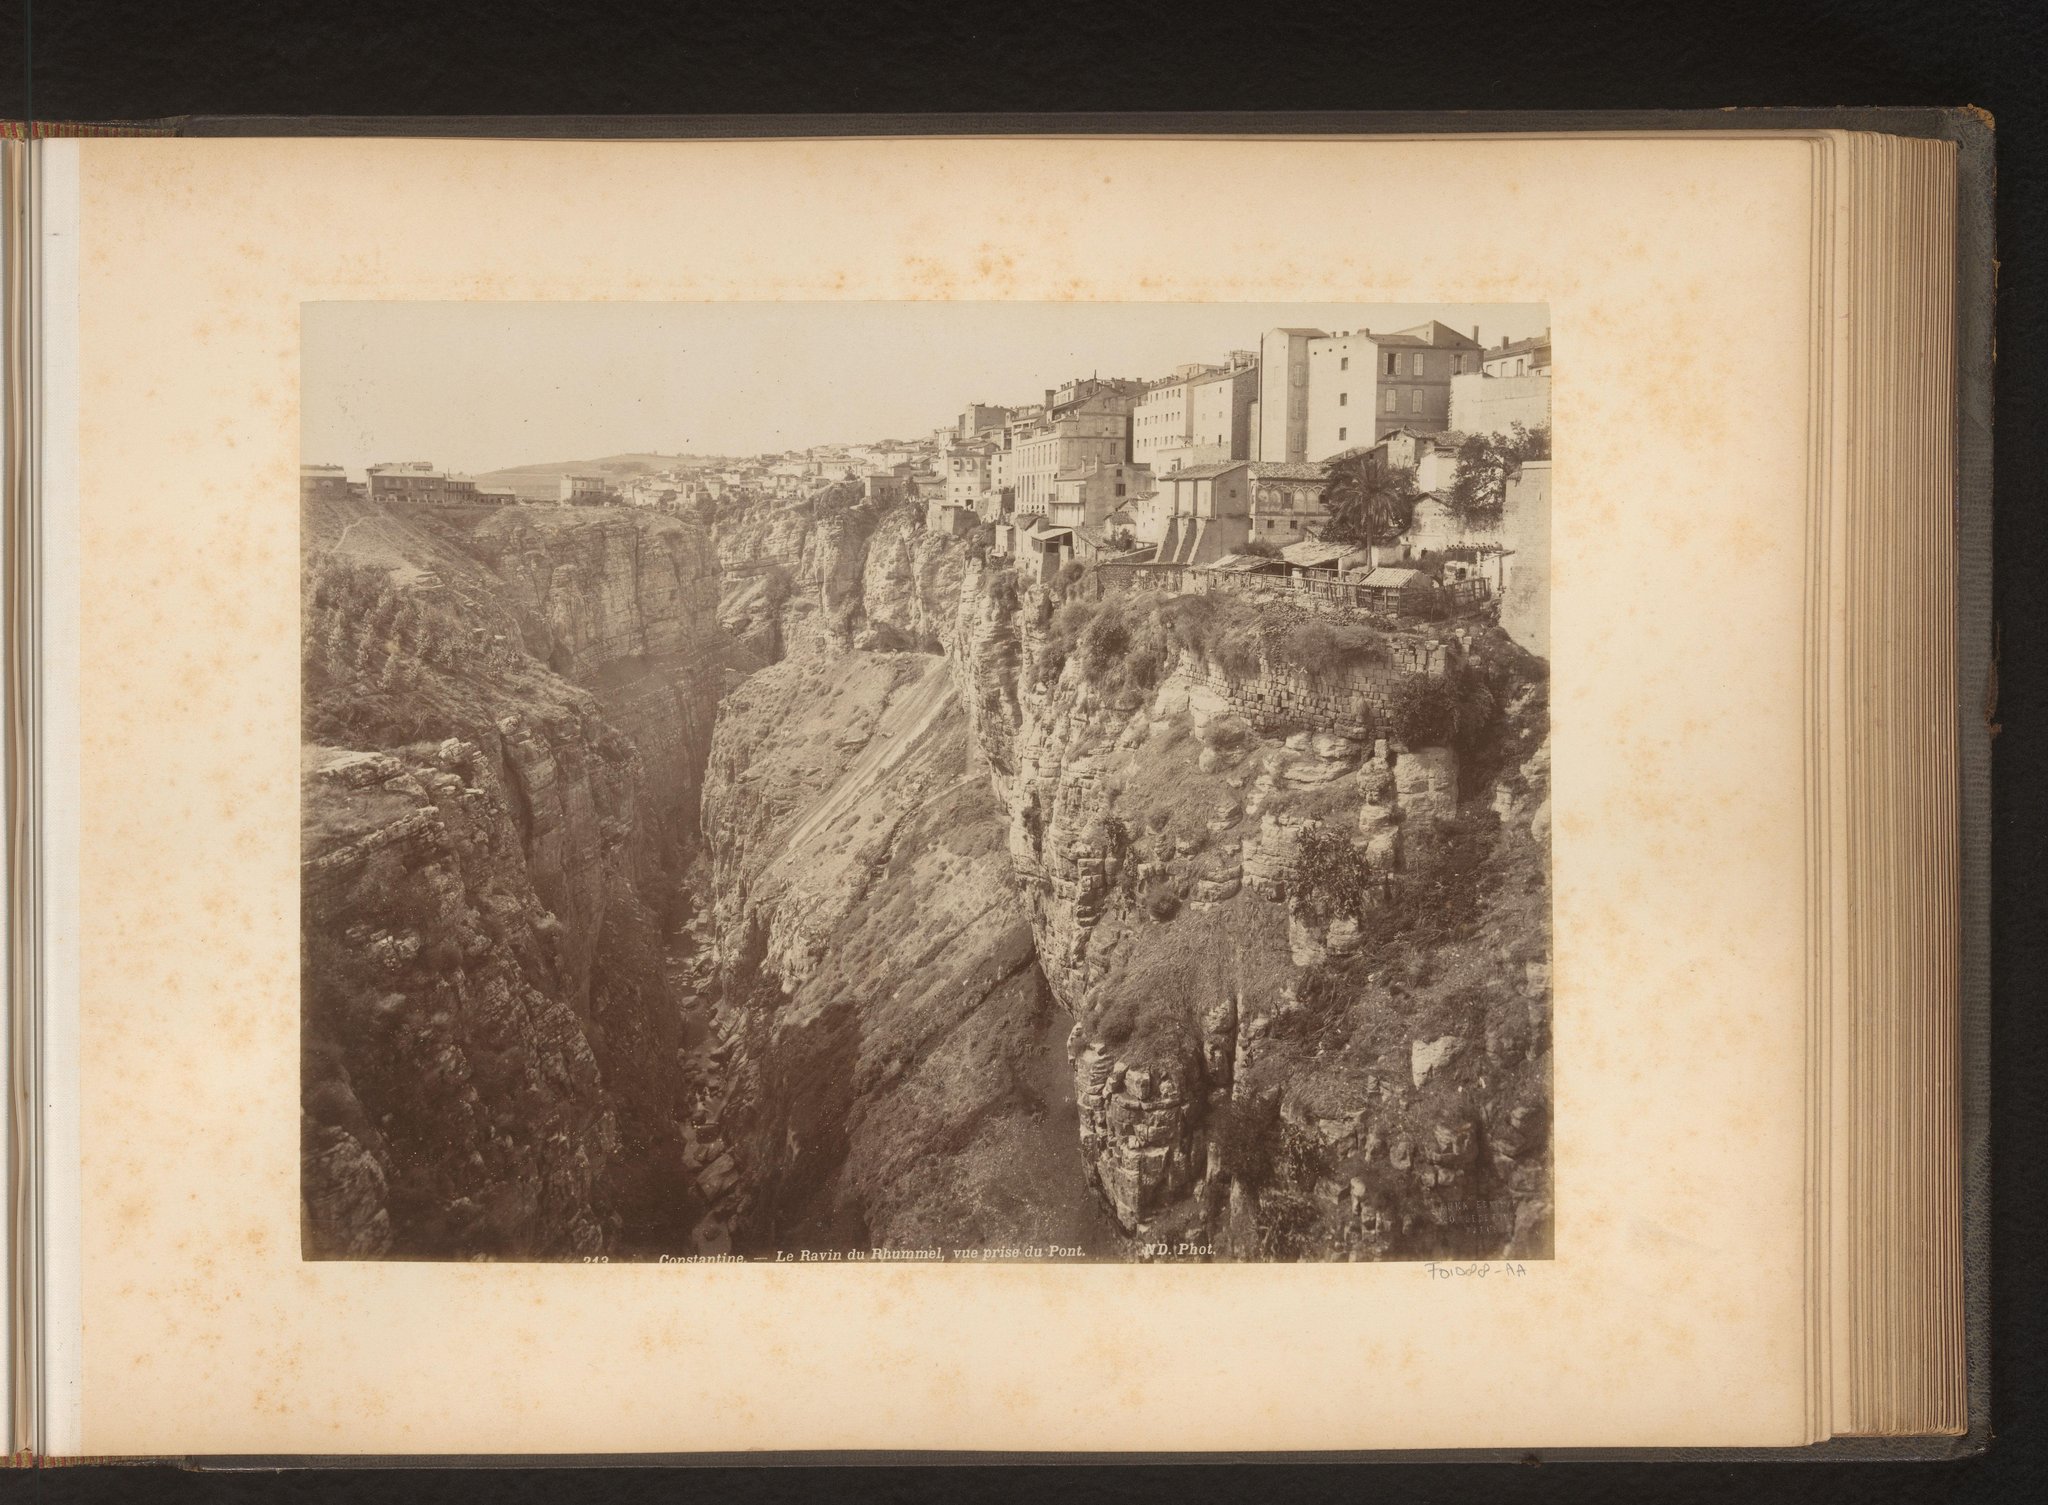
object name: photograph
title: Constantine. - Le Ravin du Rhummel, vue prise du Pont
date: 1880-1900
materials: photographic support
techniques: albumen print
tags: city-view in general; 'veduta', ravine, chasm, abyss, canyon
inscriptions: number: ‘213’, check stamp: ‘J. Kuhn Editeur/ 220 Rue de Rivoli Paris’